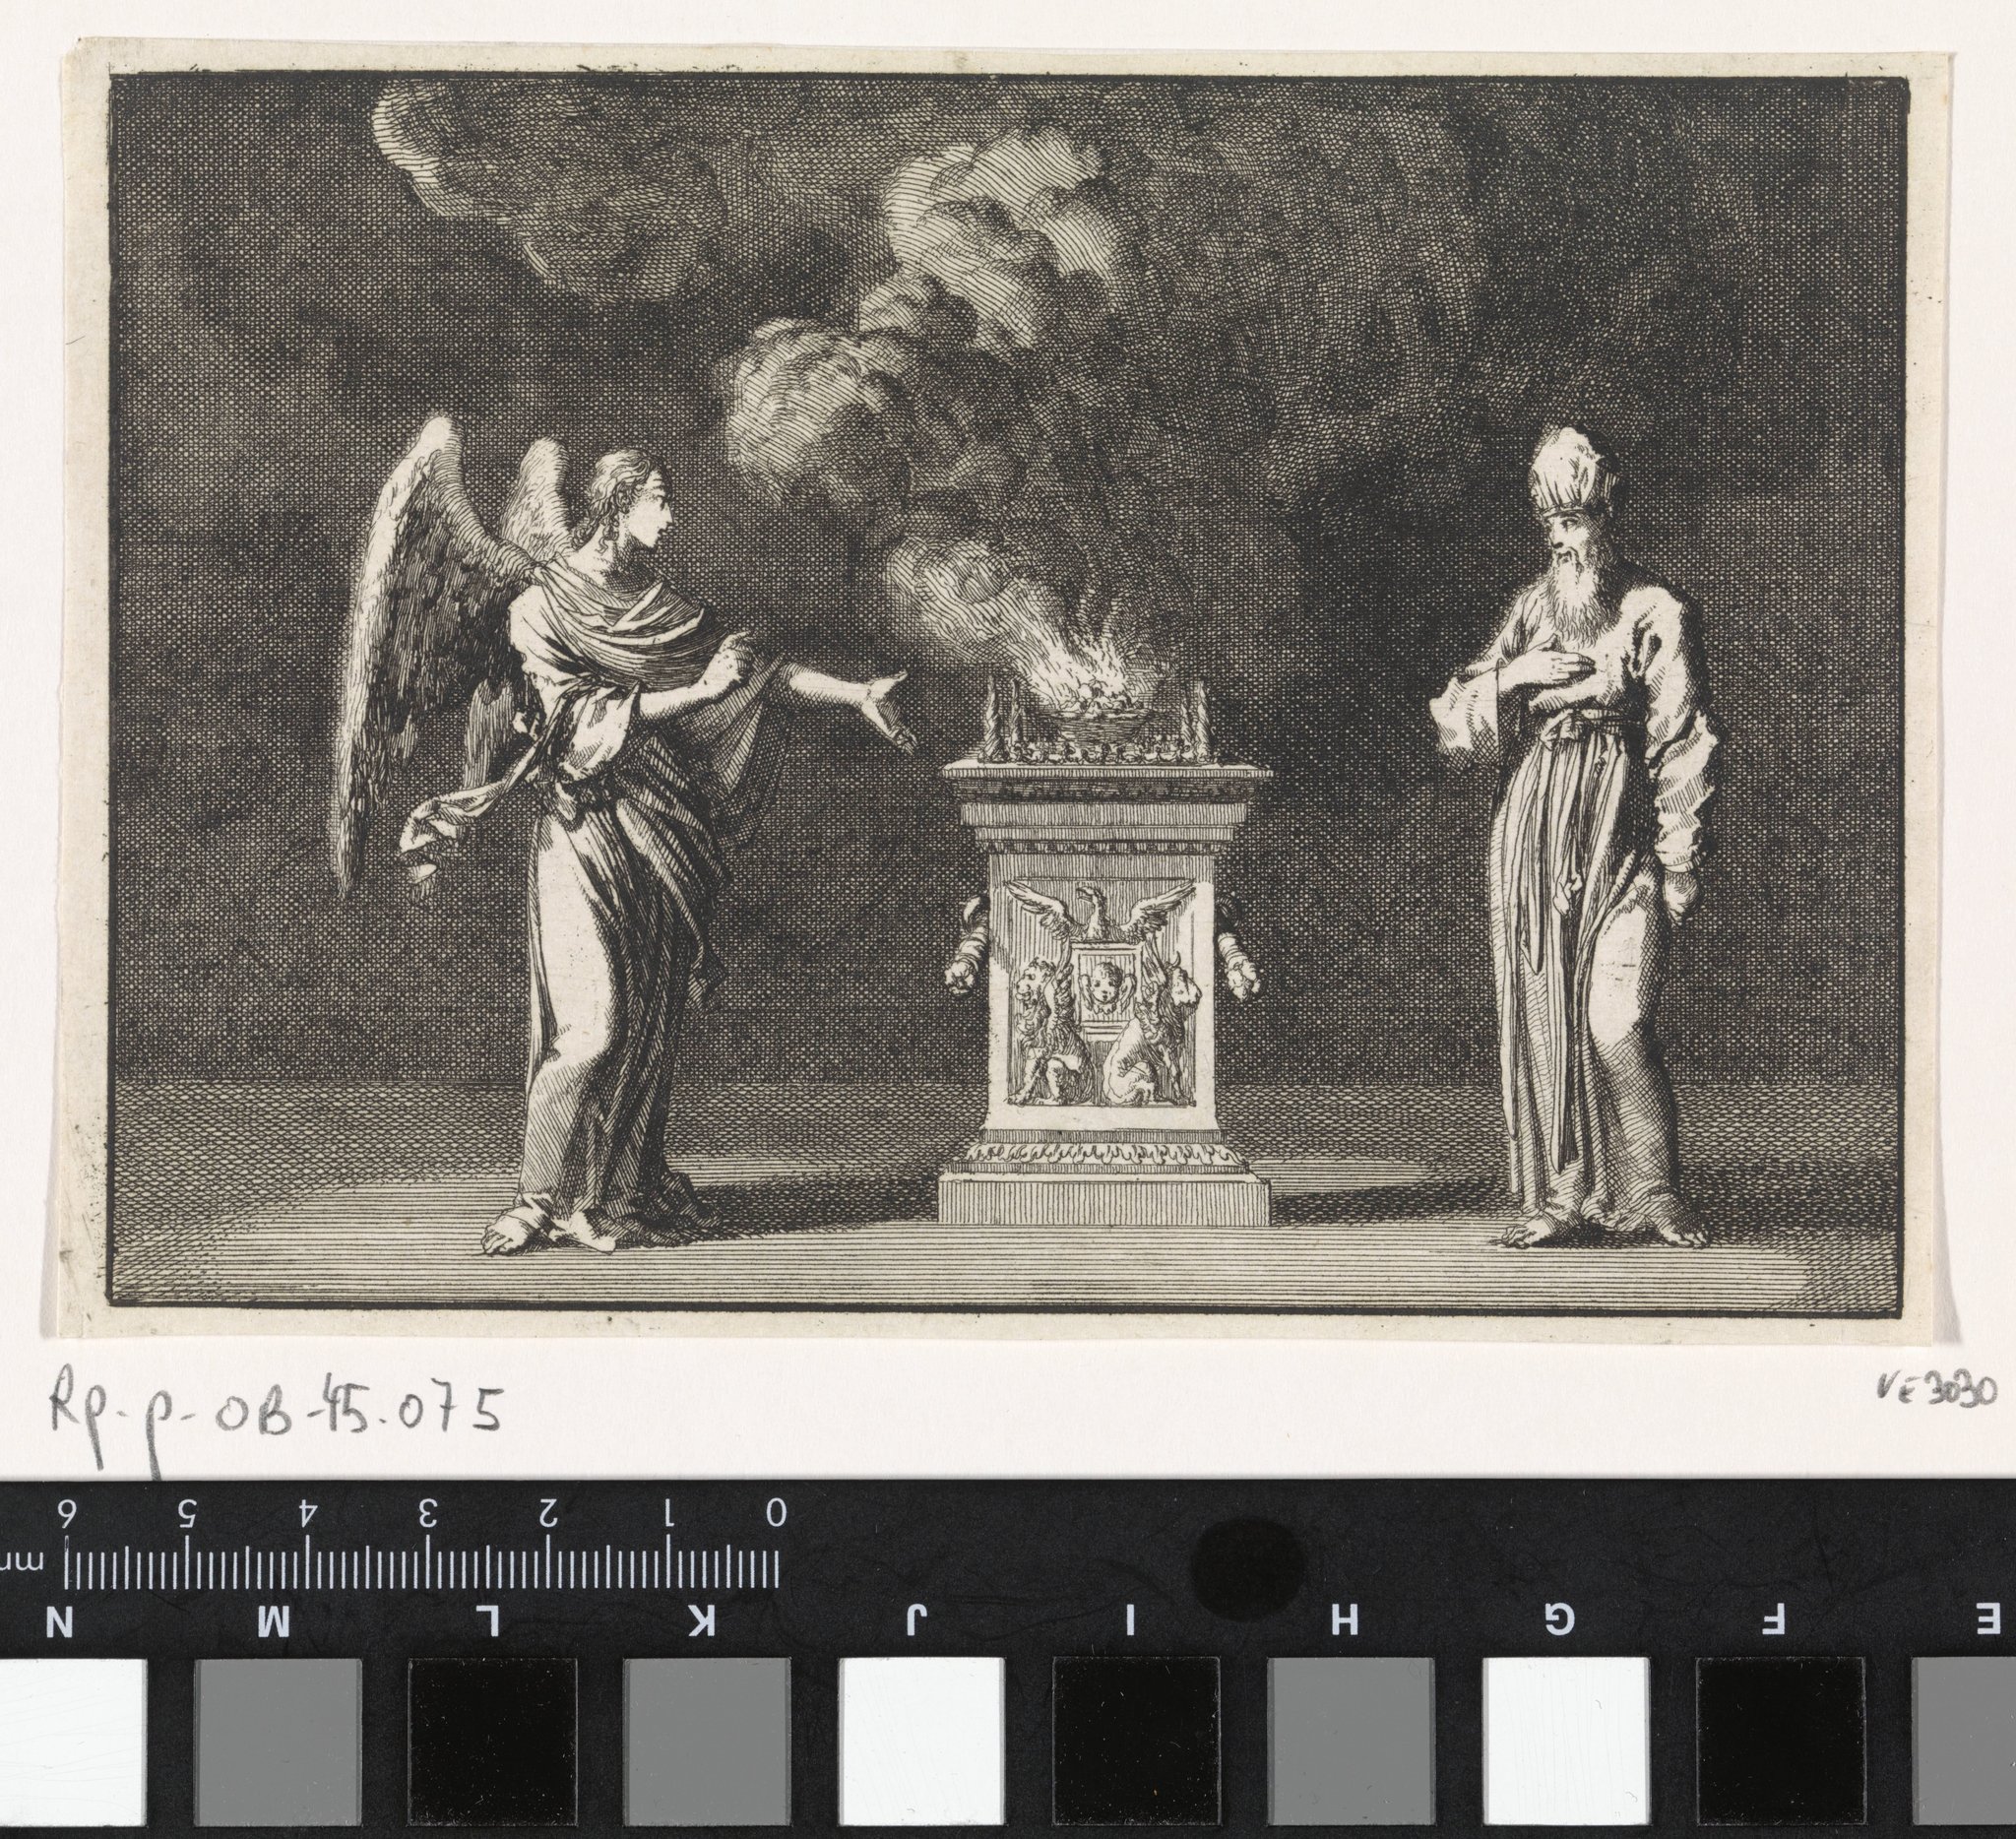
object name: print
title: Gabriël verschijnt aan Zacharias in de tempel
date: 1703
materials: paper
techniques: etching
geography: amsterdam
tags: annunciation of the birth of john the baptist to zacharias: while he is offering incense in the temple an angel (gabriel) appears to him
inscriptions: collector's mark: Lugt 2228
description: Proefdruk van een boekillustratie voor David Martin. Historie des Ouden en Nieuwen Testaments. Amsterdam, Pieter Mortier, 1703. Deel II. De boekillustraties voor de Mortierbijbel hebben verschillende staten en kopieën, waarbij de chronologische volgorde moeilijk te achterhalen valt. Als boekillustraties werden ze bovendien herhaaldelijk opnieuw gebruikt voor andere boekwerken.